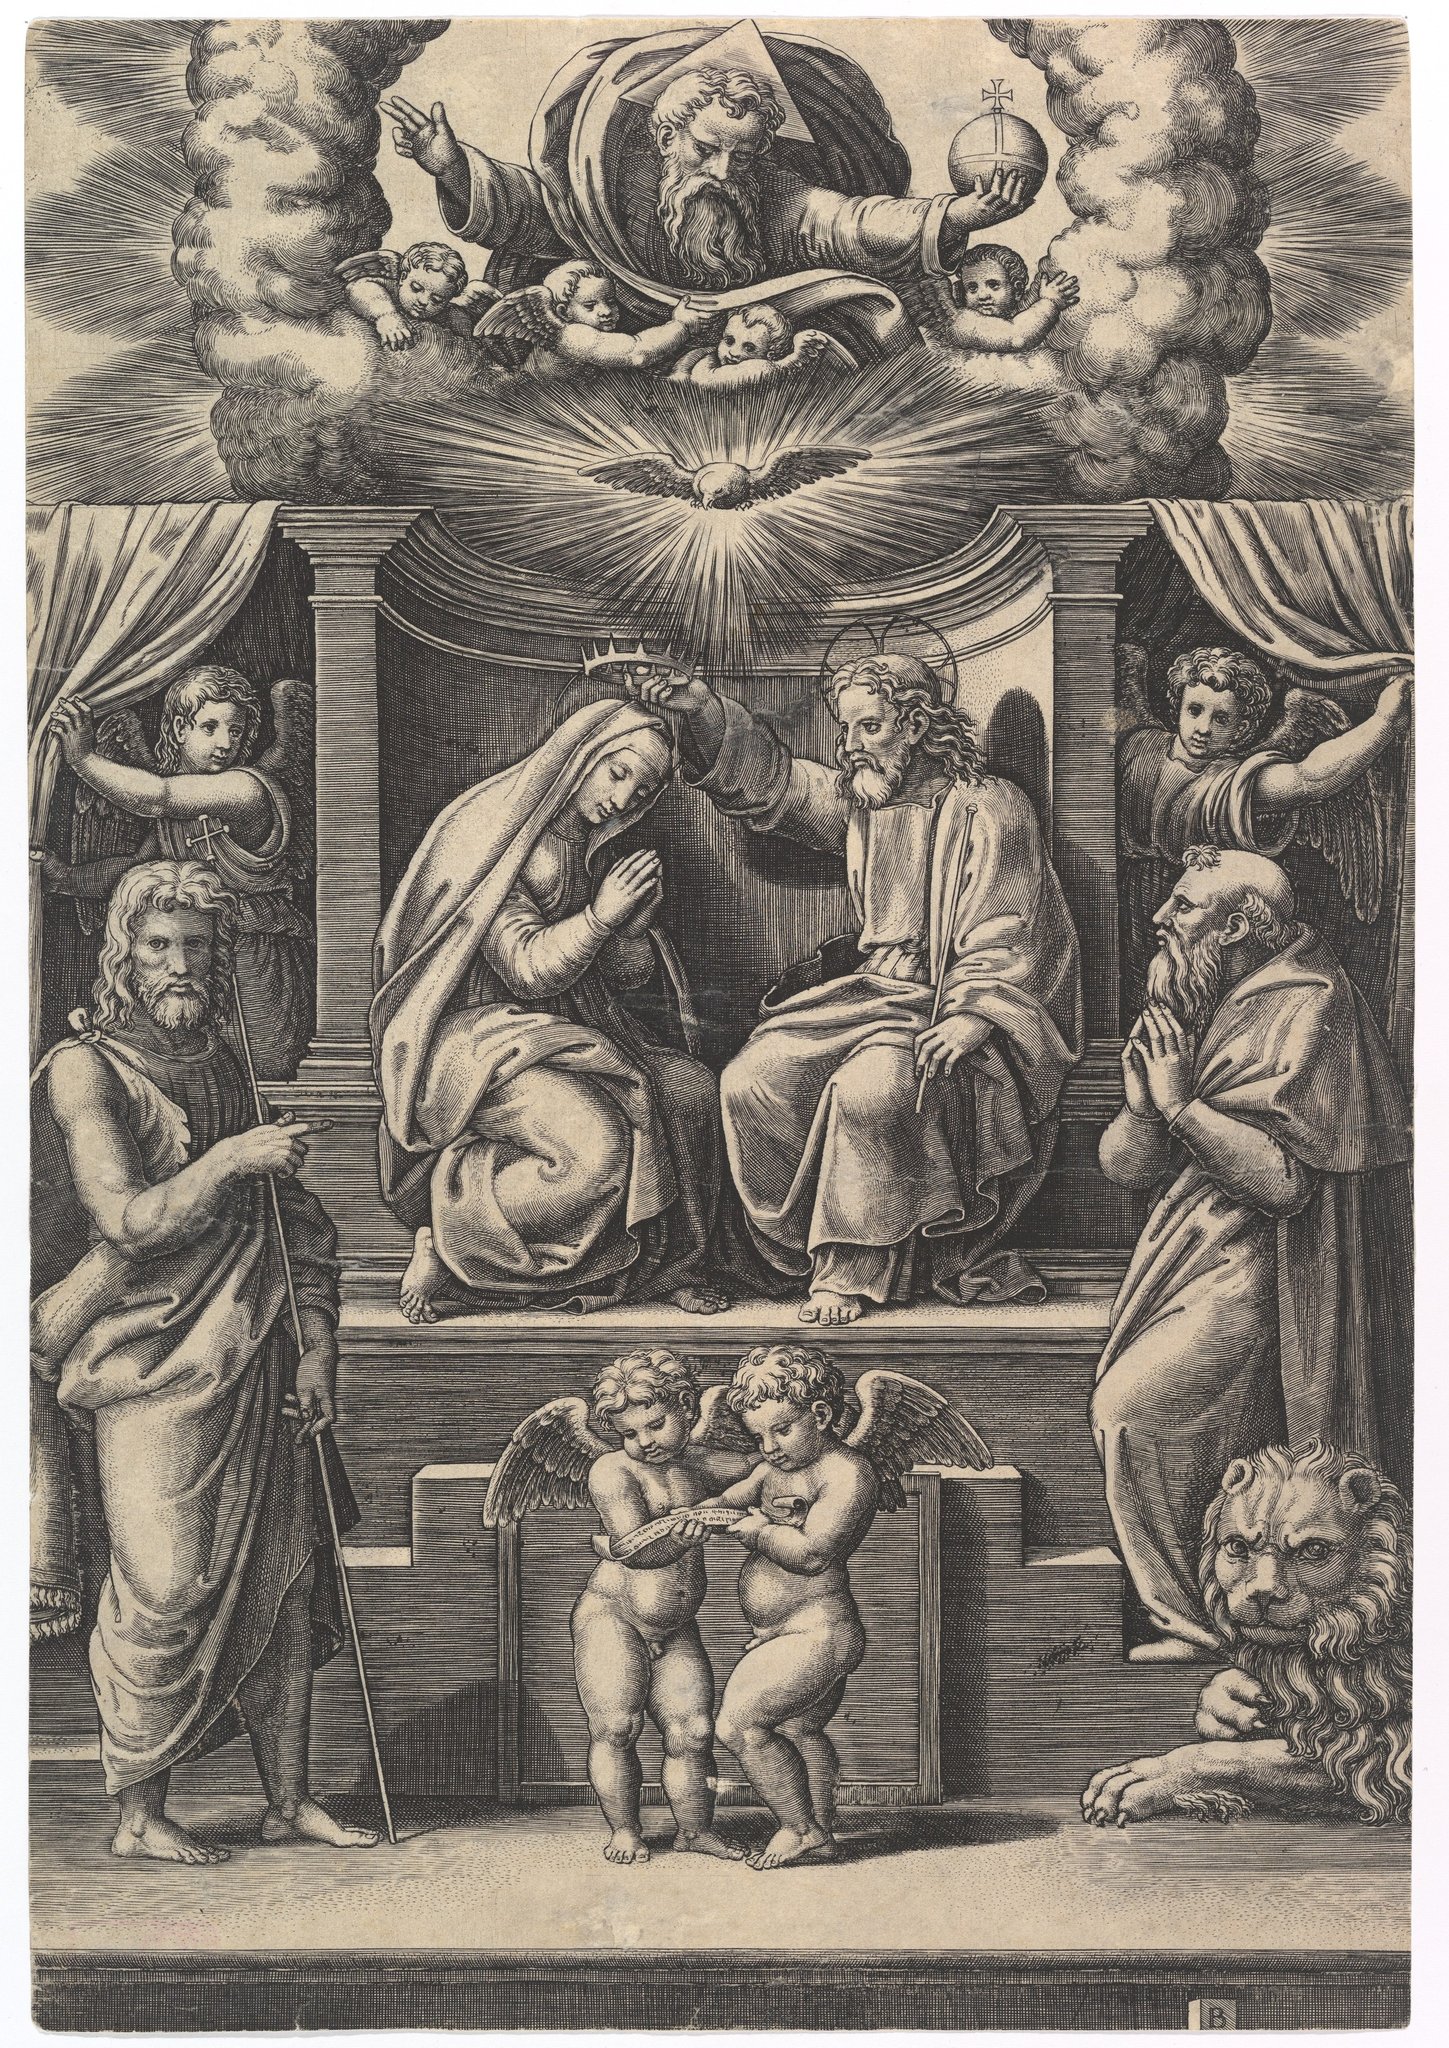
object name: print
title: The Coronation of the Virgin, at lower left stands St John the Baptist, at lower right St Jerome, God the father above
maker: master of the die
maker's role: artist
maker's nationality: italian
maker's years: 1525-1560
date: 1530-1560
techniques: engraving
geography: germany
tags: putti,lions,saint john the baptist,virgin mary,coronation of the virgin